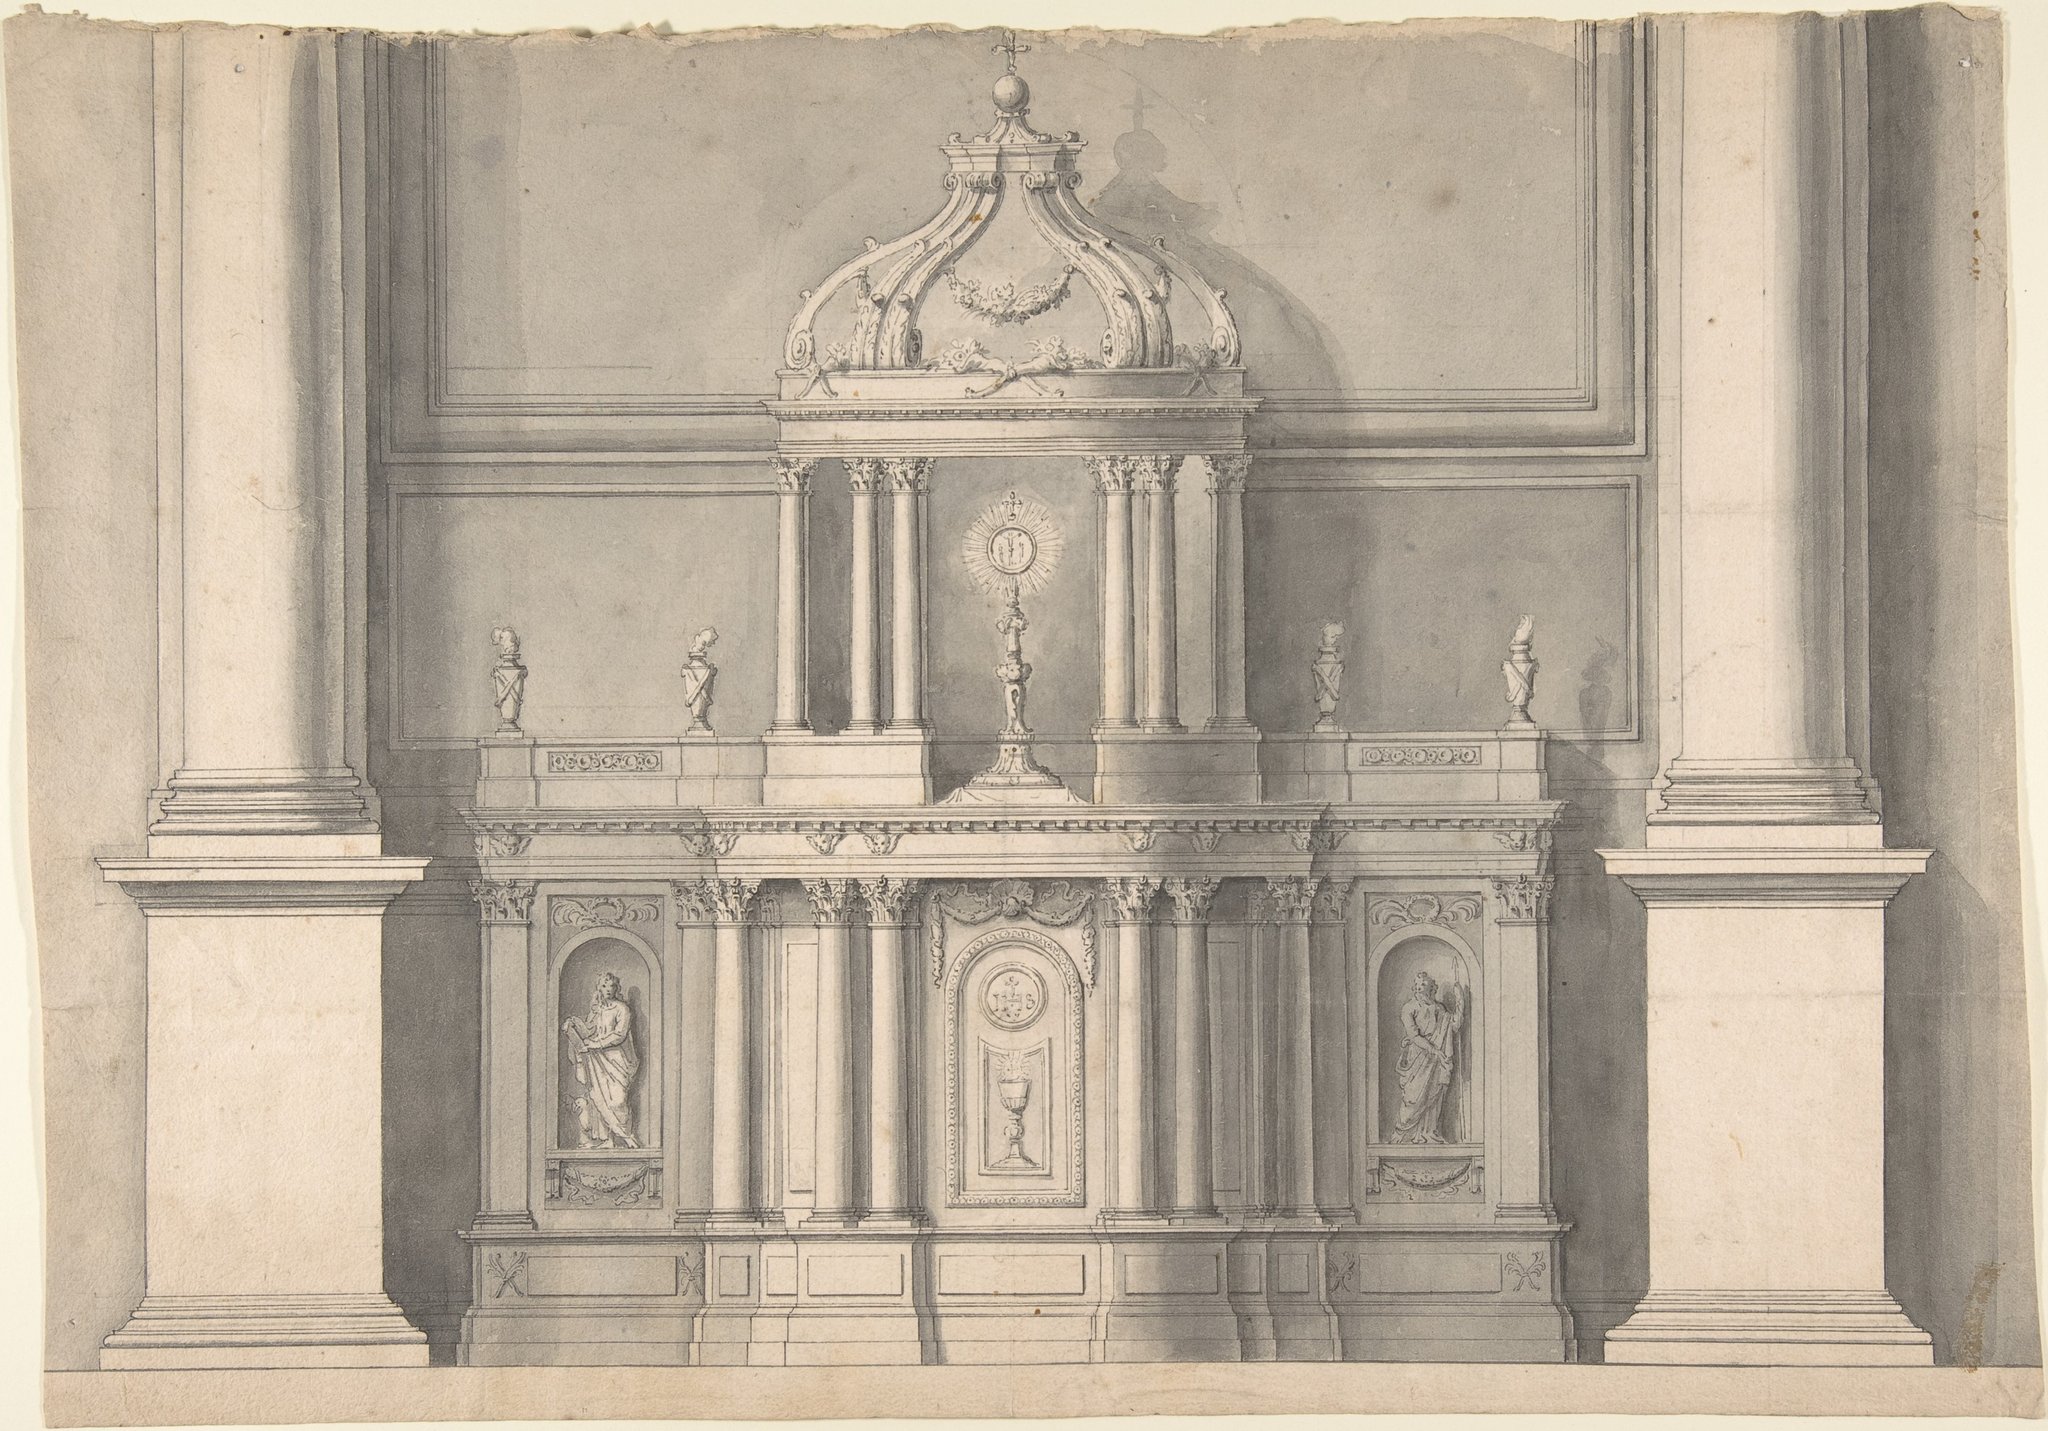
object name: drawing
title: Design for a Tabernacle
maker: anonymous, french, 18th century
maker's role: artist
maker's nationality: french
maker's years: 1700-1800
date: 1701-1800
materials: ink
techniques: brush, pen, wash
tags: architecture,tabernacles